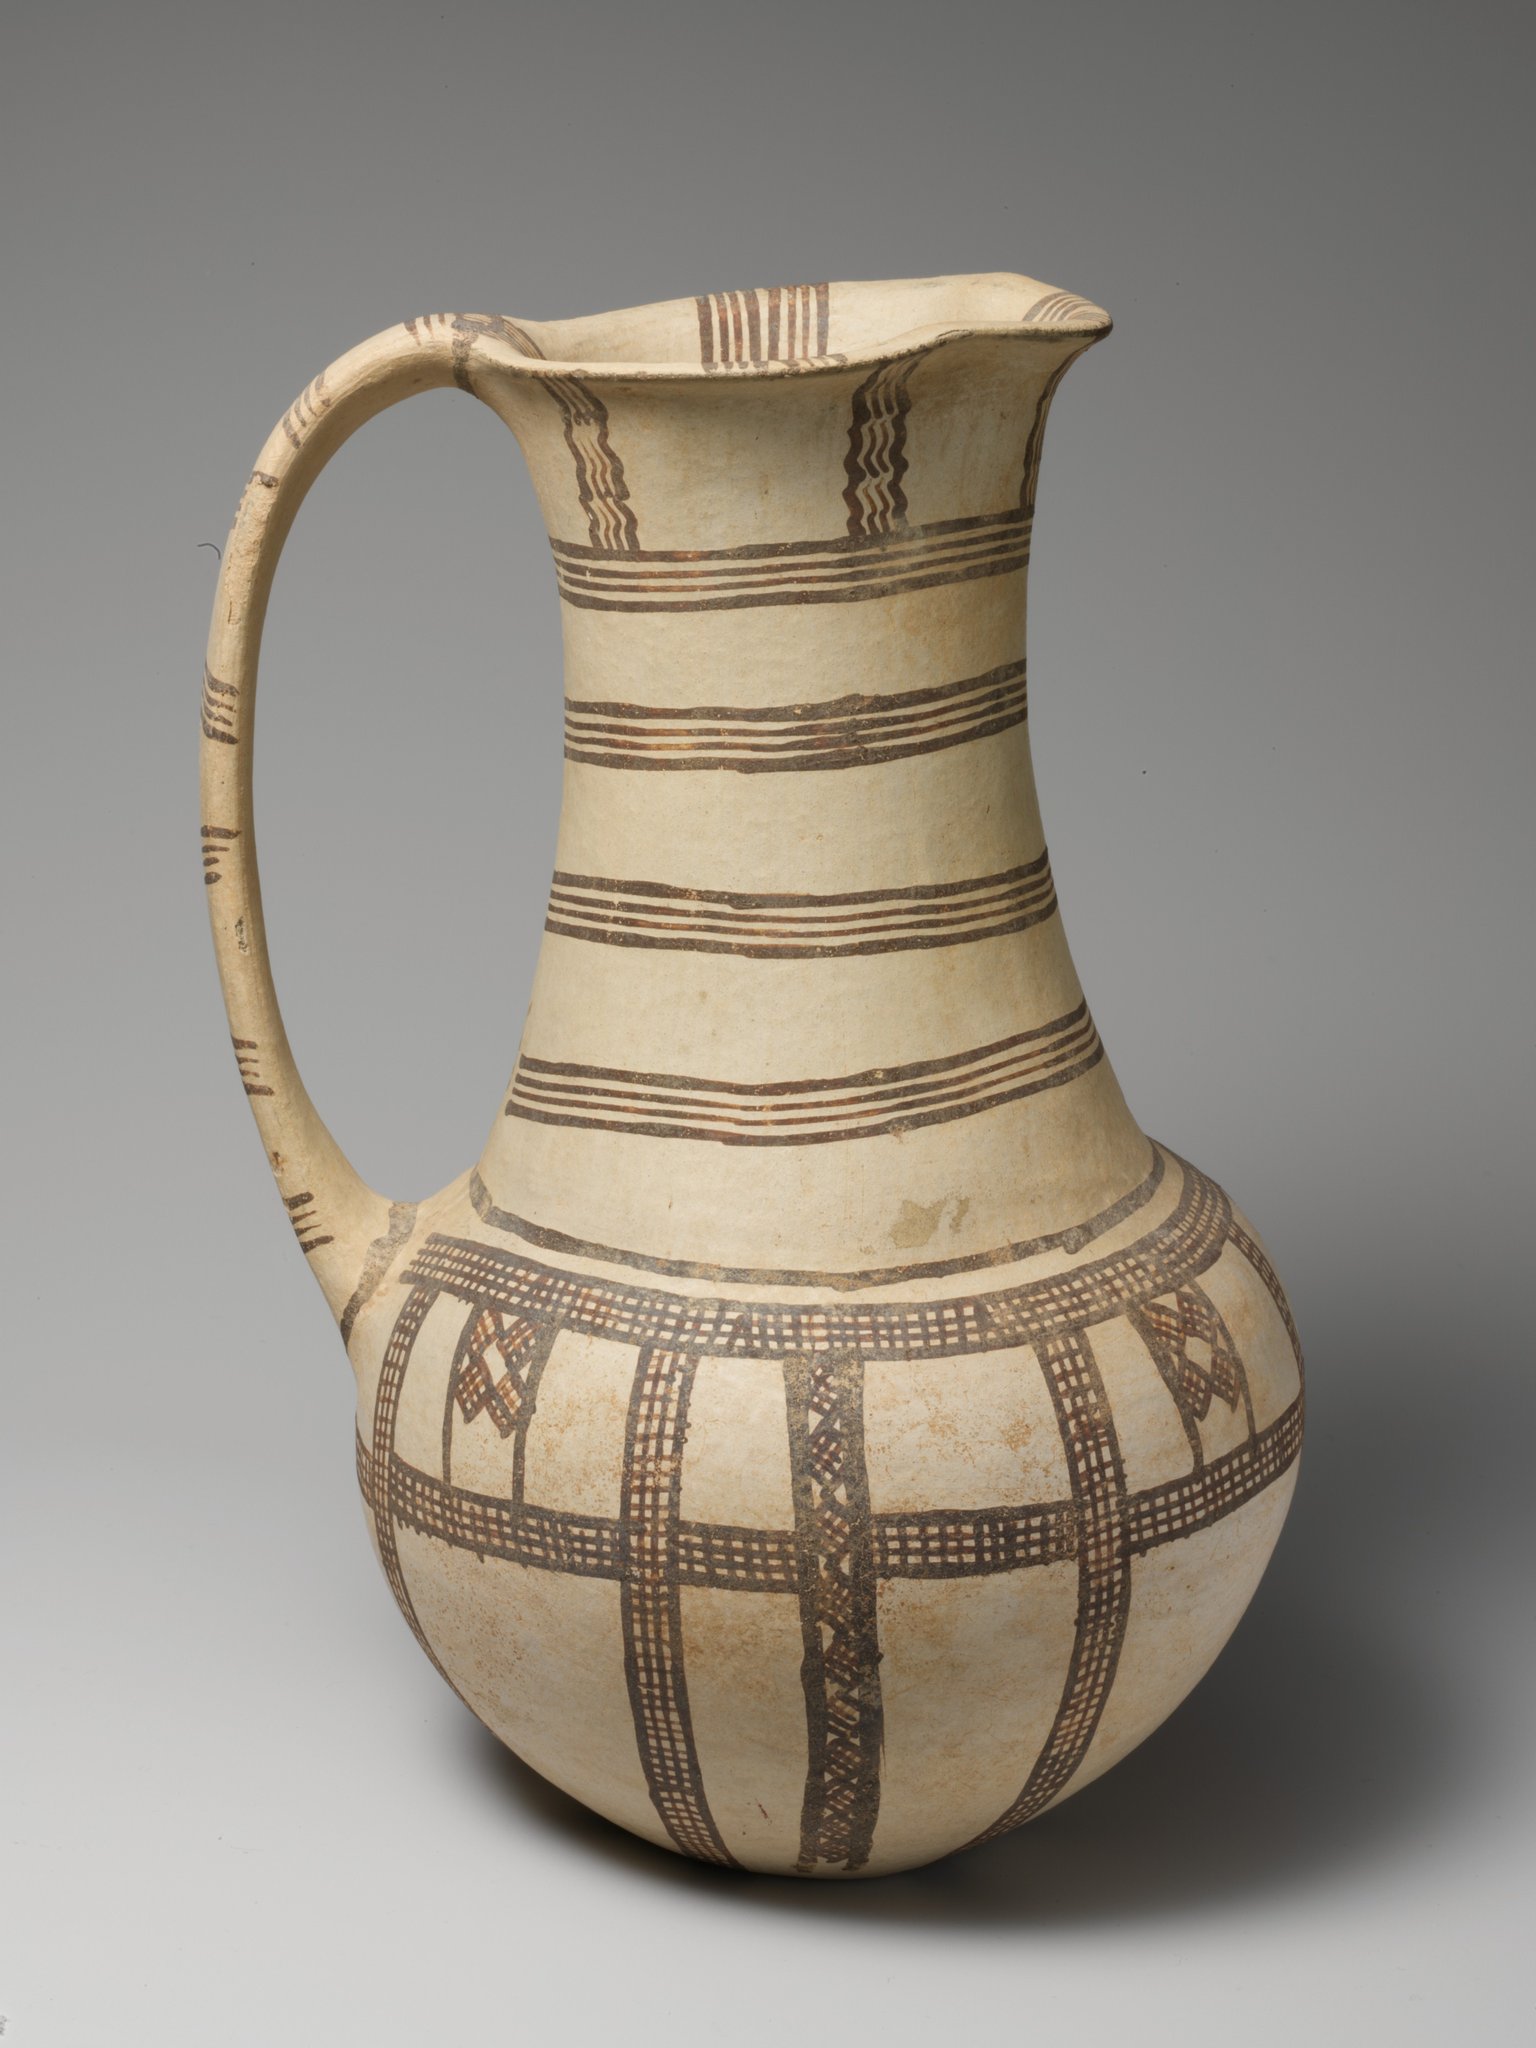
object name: jug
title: Terracotta jug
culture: cypriot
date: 1600-1150 BCE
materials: terracotta